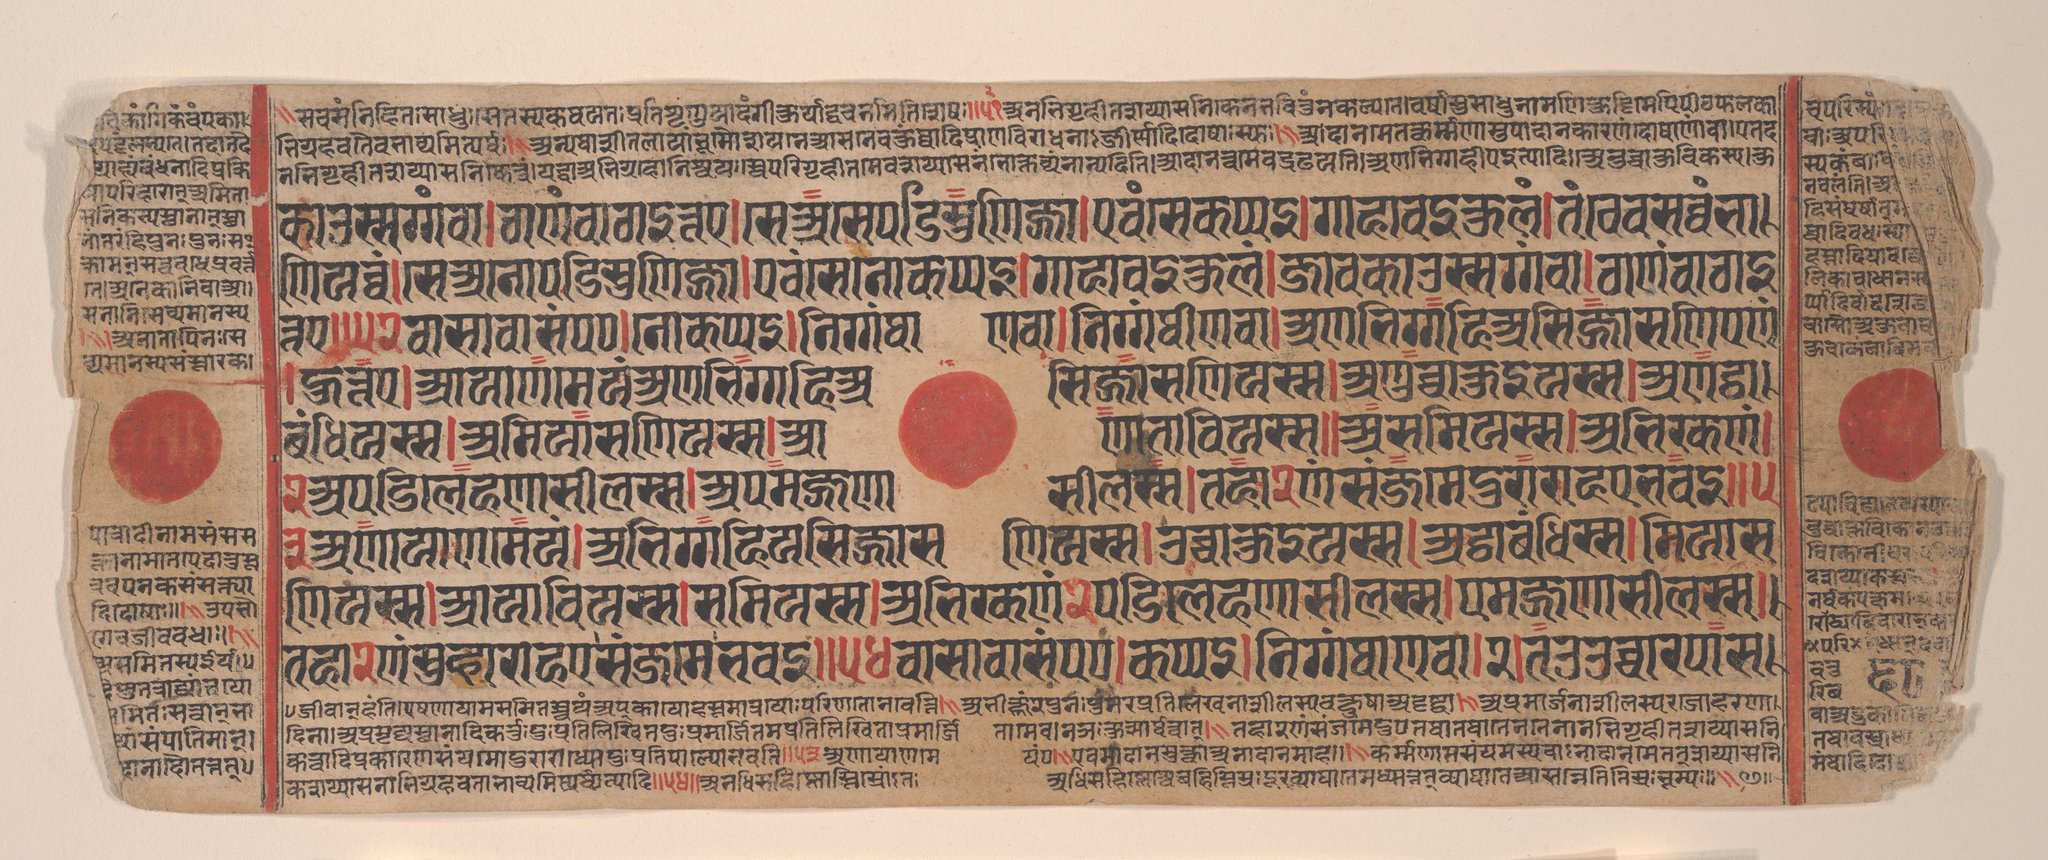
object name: folio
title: Leaf from a Kalpa Sutra (Jain Book of Rituals)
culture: indian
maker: bhadrabahu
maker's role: artist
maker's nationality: indian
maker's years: 356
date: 1401-1500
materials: gold, ink, paper, watercolor